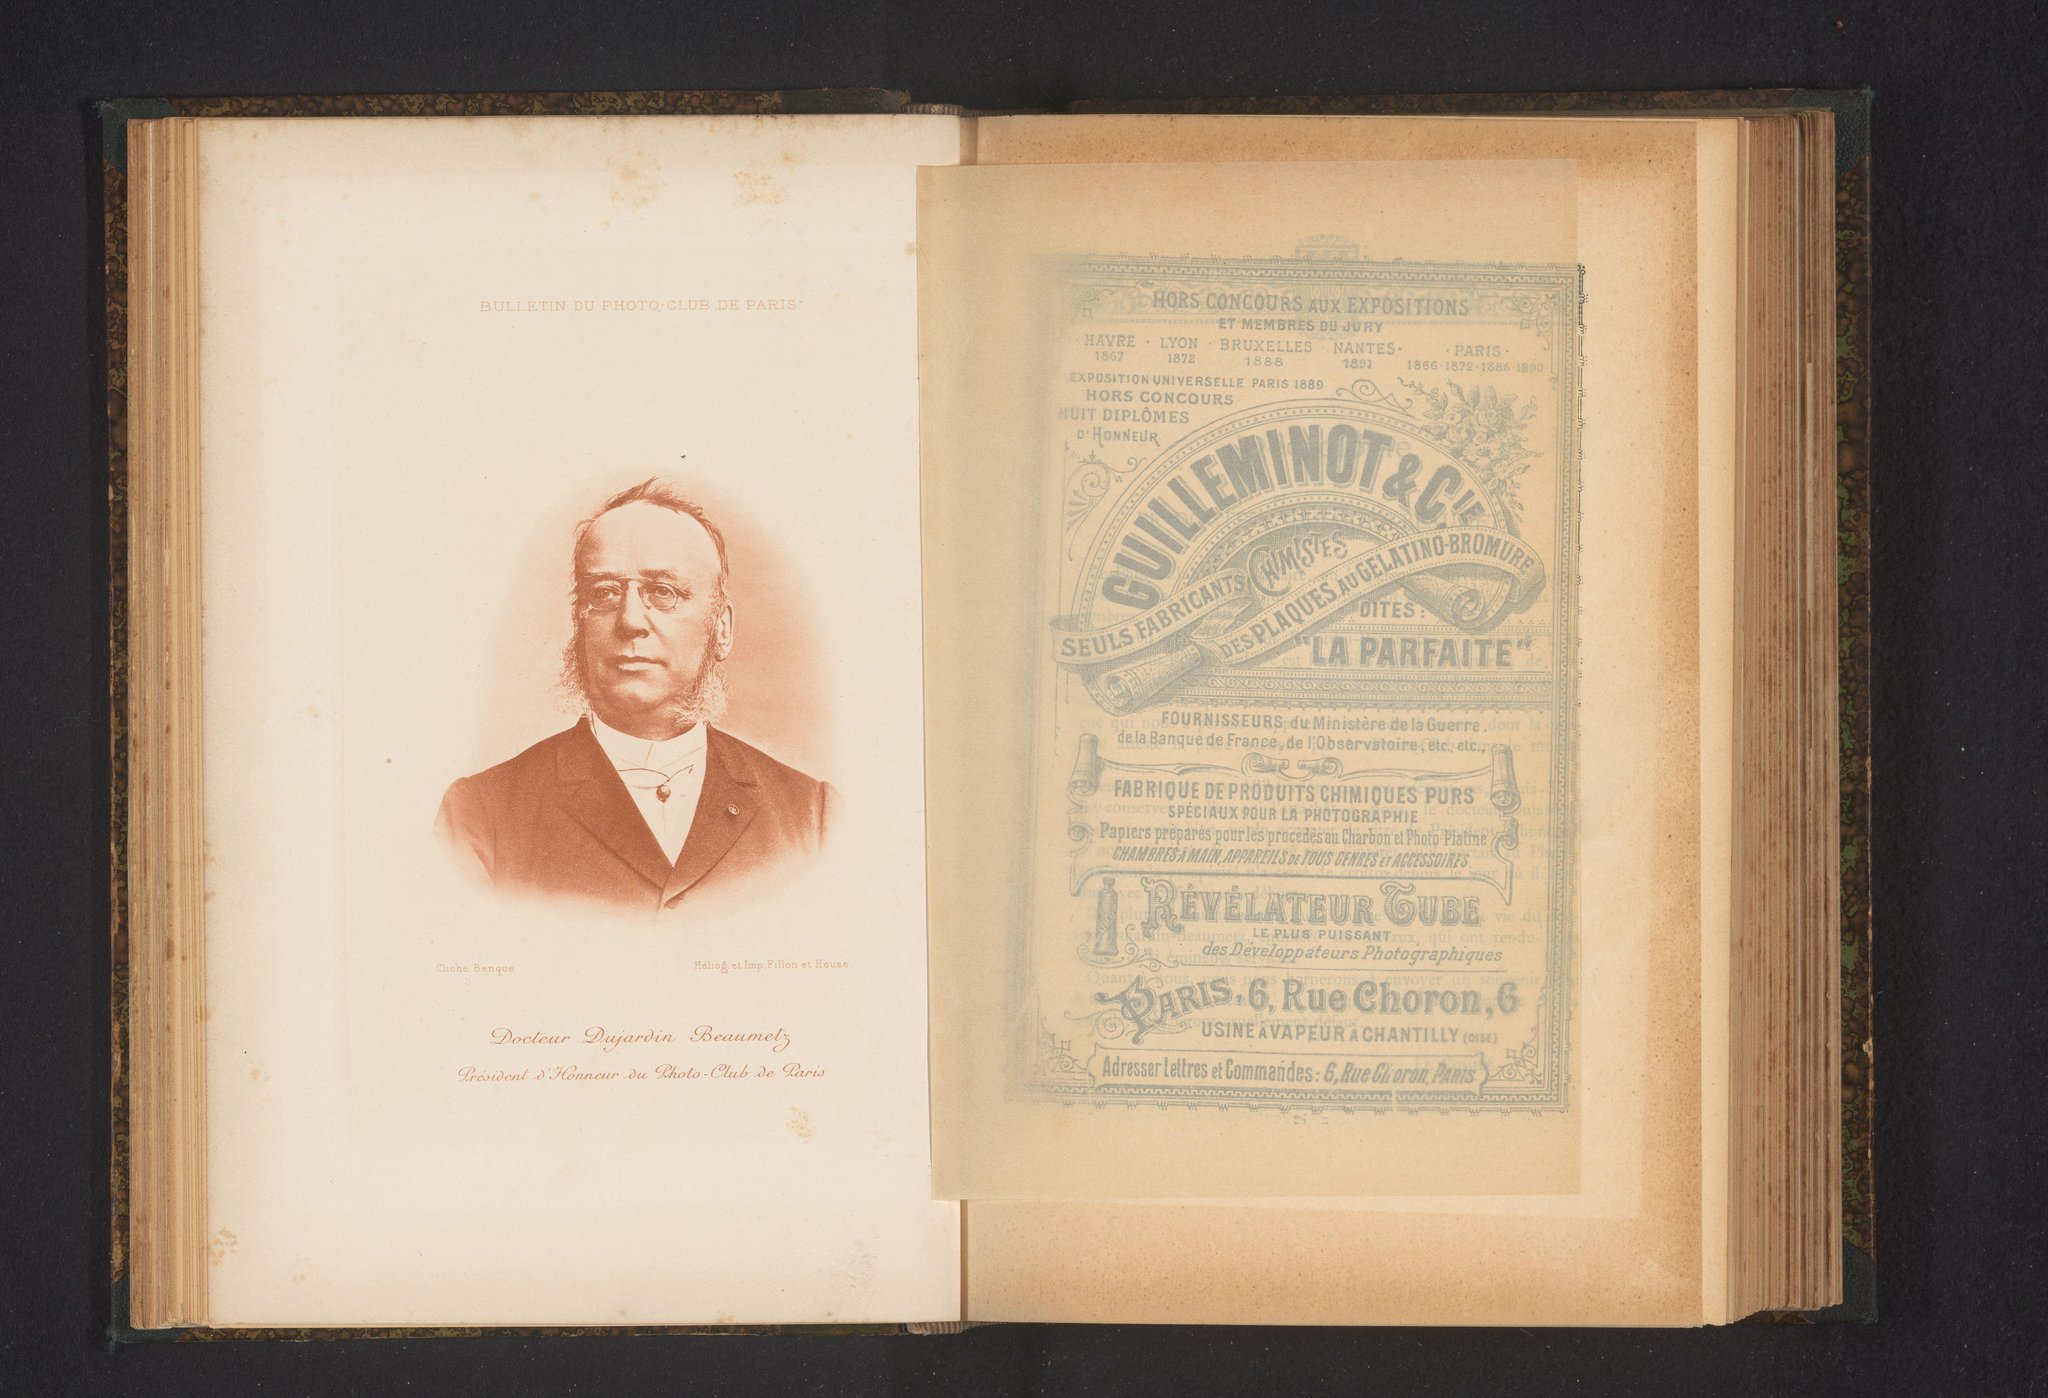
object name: photomechanical print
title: Docteur Dujardin Beaumetz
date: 1890-1895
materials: paper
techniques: photoaquatint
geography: paris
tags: paris, historical persons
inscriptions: inscription: ‘Bulletin du Photo-Club de Paris’, inscription: ‘Président d'Honneur du Photo-Club de Paris ’